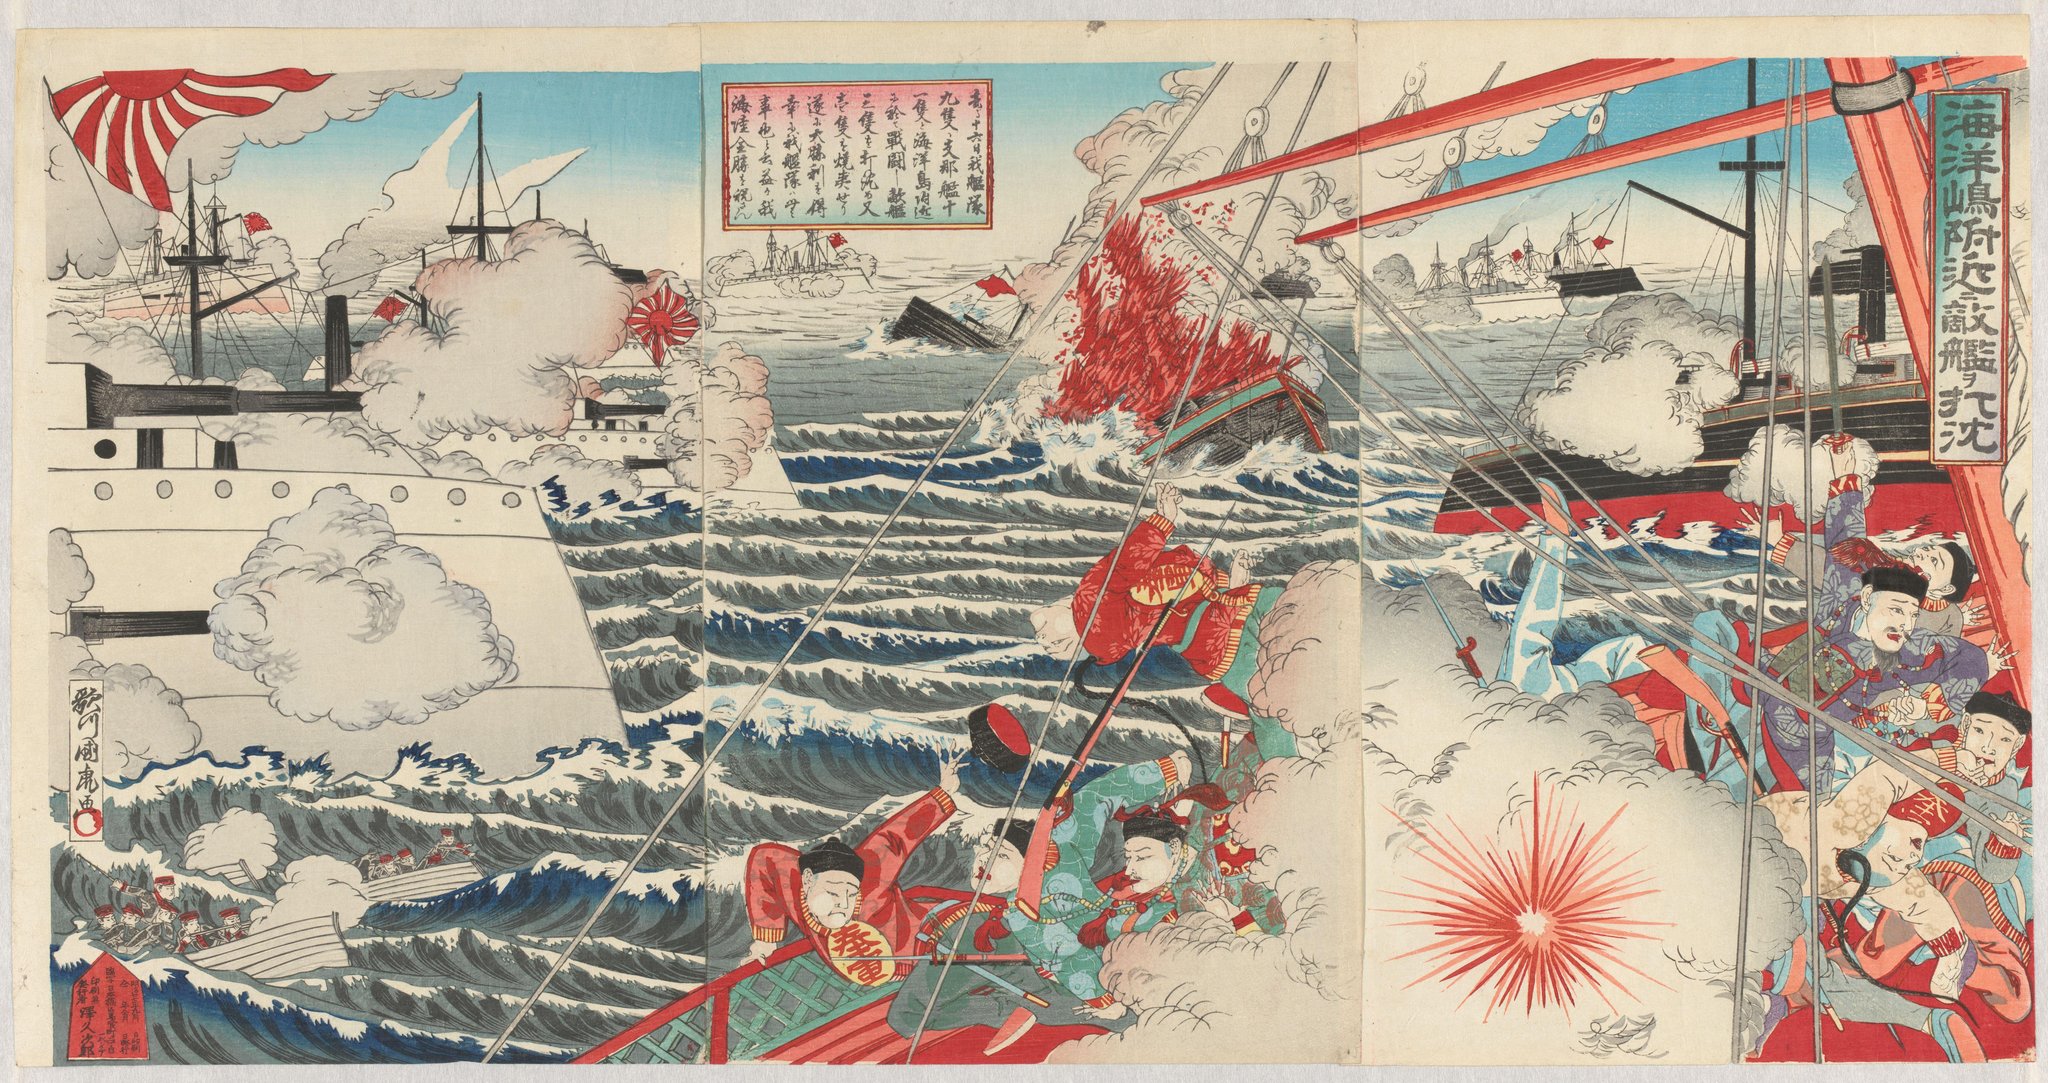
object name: print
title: Enemy Ships Deterred at Haiyangdao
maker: utagawa kunitora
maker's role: print maker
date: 1894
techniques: woodcut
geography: japan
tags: battle (+ naval force)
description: In the struggle for power in Korea between the Chinese and the Japanese armies it was vital to safeguard the equipment and provisioning of the troops. To this end, control of the Yellow Sea between the Korean peninsula and the Chinese mainland was crucial. The Japanese strategy was to force a decisive battle with the Chinese navy.